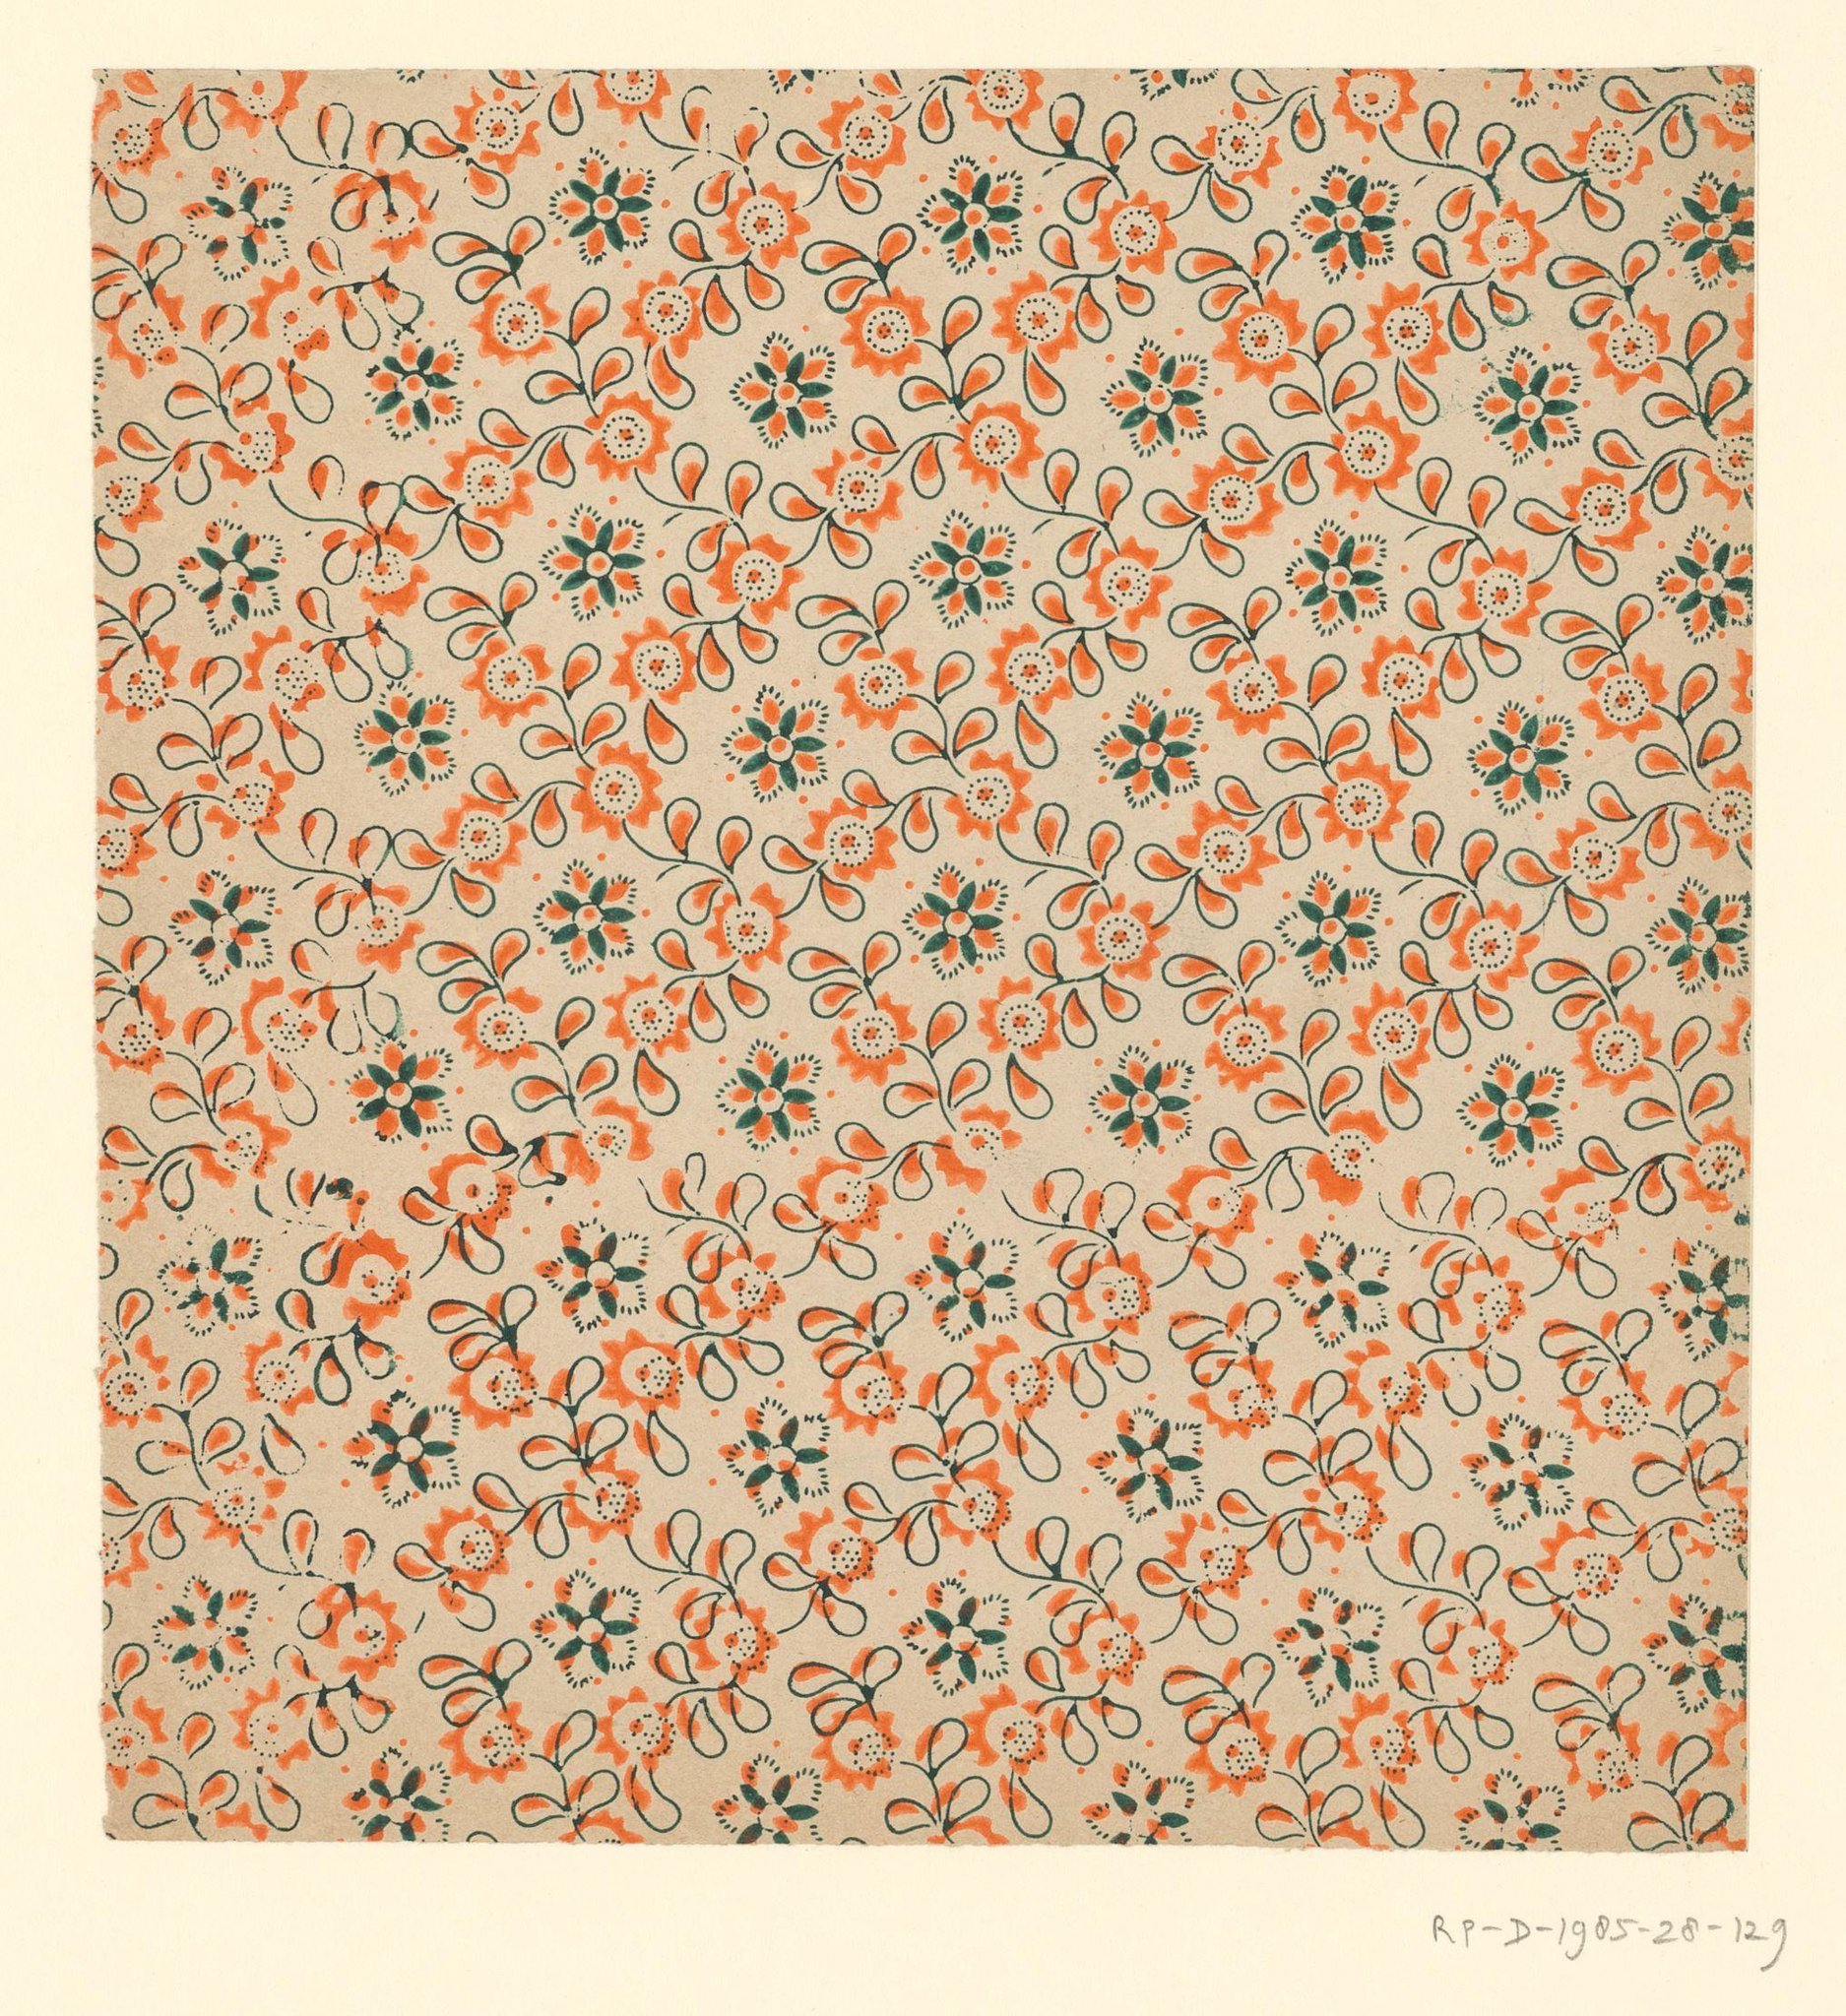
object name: wrapper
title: Blad met strooipatroon van bloemtakken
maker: Anonymous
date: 1750-1900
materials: paper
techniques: printing block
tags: fantasy ornament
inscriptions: collector's mark: Lugt 2228, collector's mark: Lugt 2760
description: Blad met strooipatroon van bloemtakken. Waarschijnlijk de helft van een omslag.